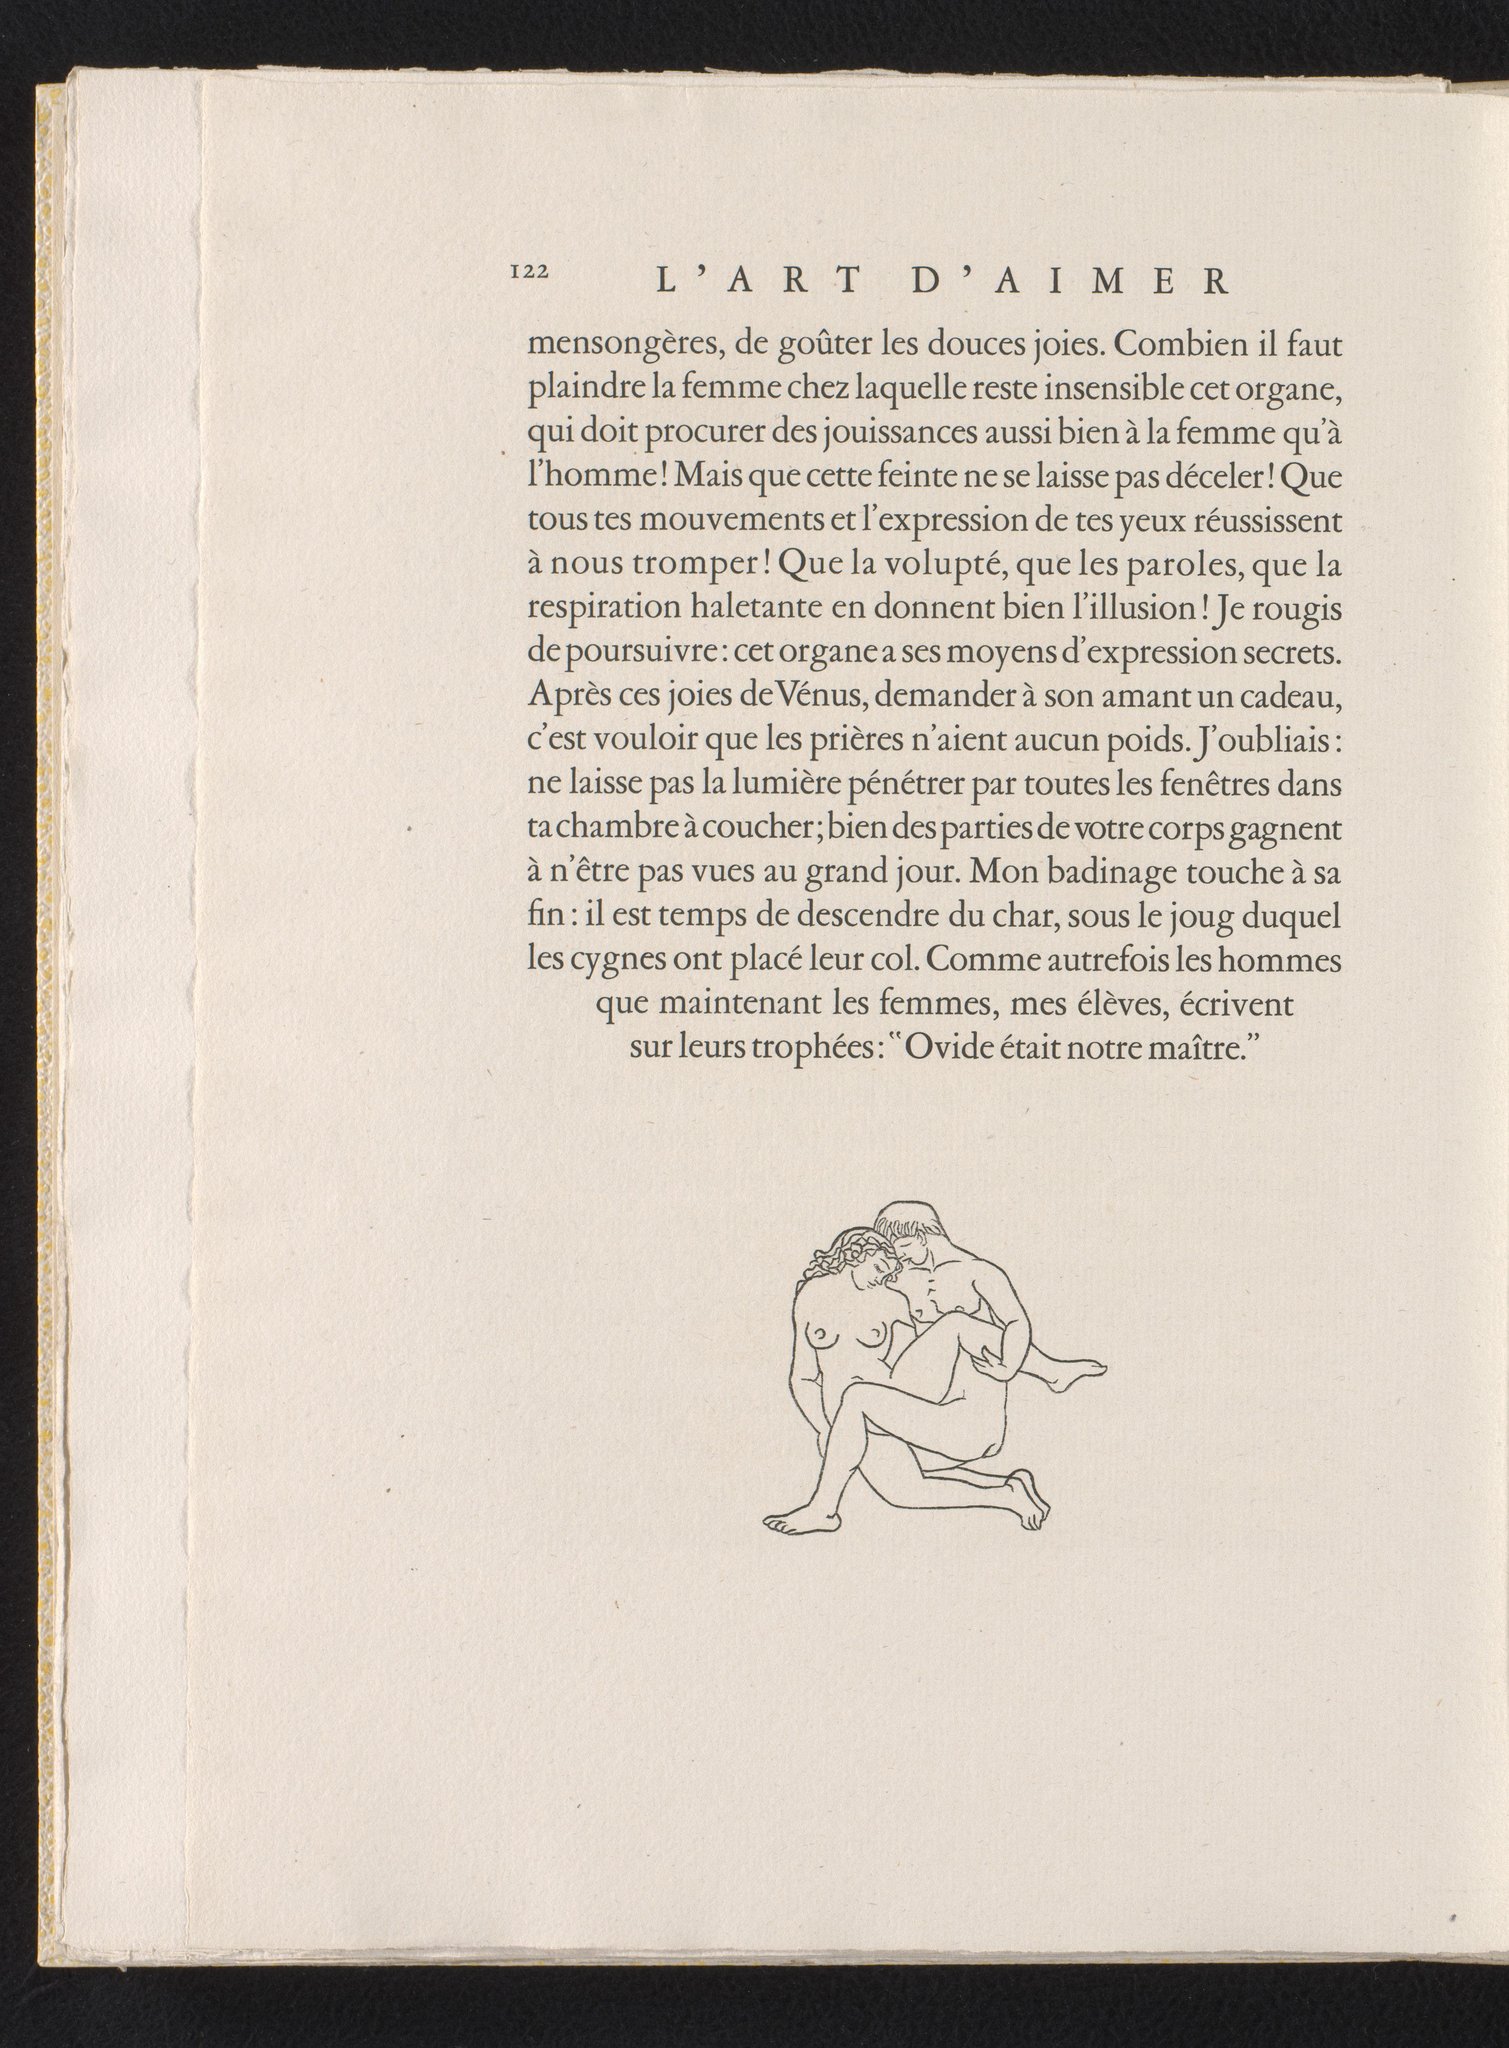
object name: print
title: Vrijend paar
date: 1935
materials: paper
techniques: letterpress printing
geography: lausanne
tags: couple of lovers, coitus, cohabiting, sexual intercourse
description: Prent in: Ovidius Naso, Publius. L'art d'aimer. [Vertaald uit het Latijn door] Henri Bornecque. Parijs/Lausanne: Les frères Gonin, 1935, p. 122.